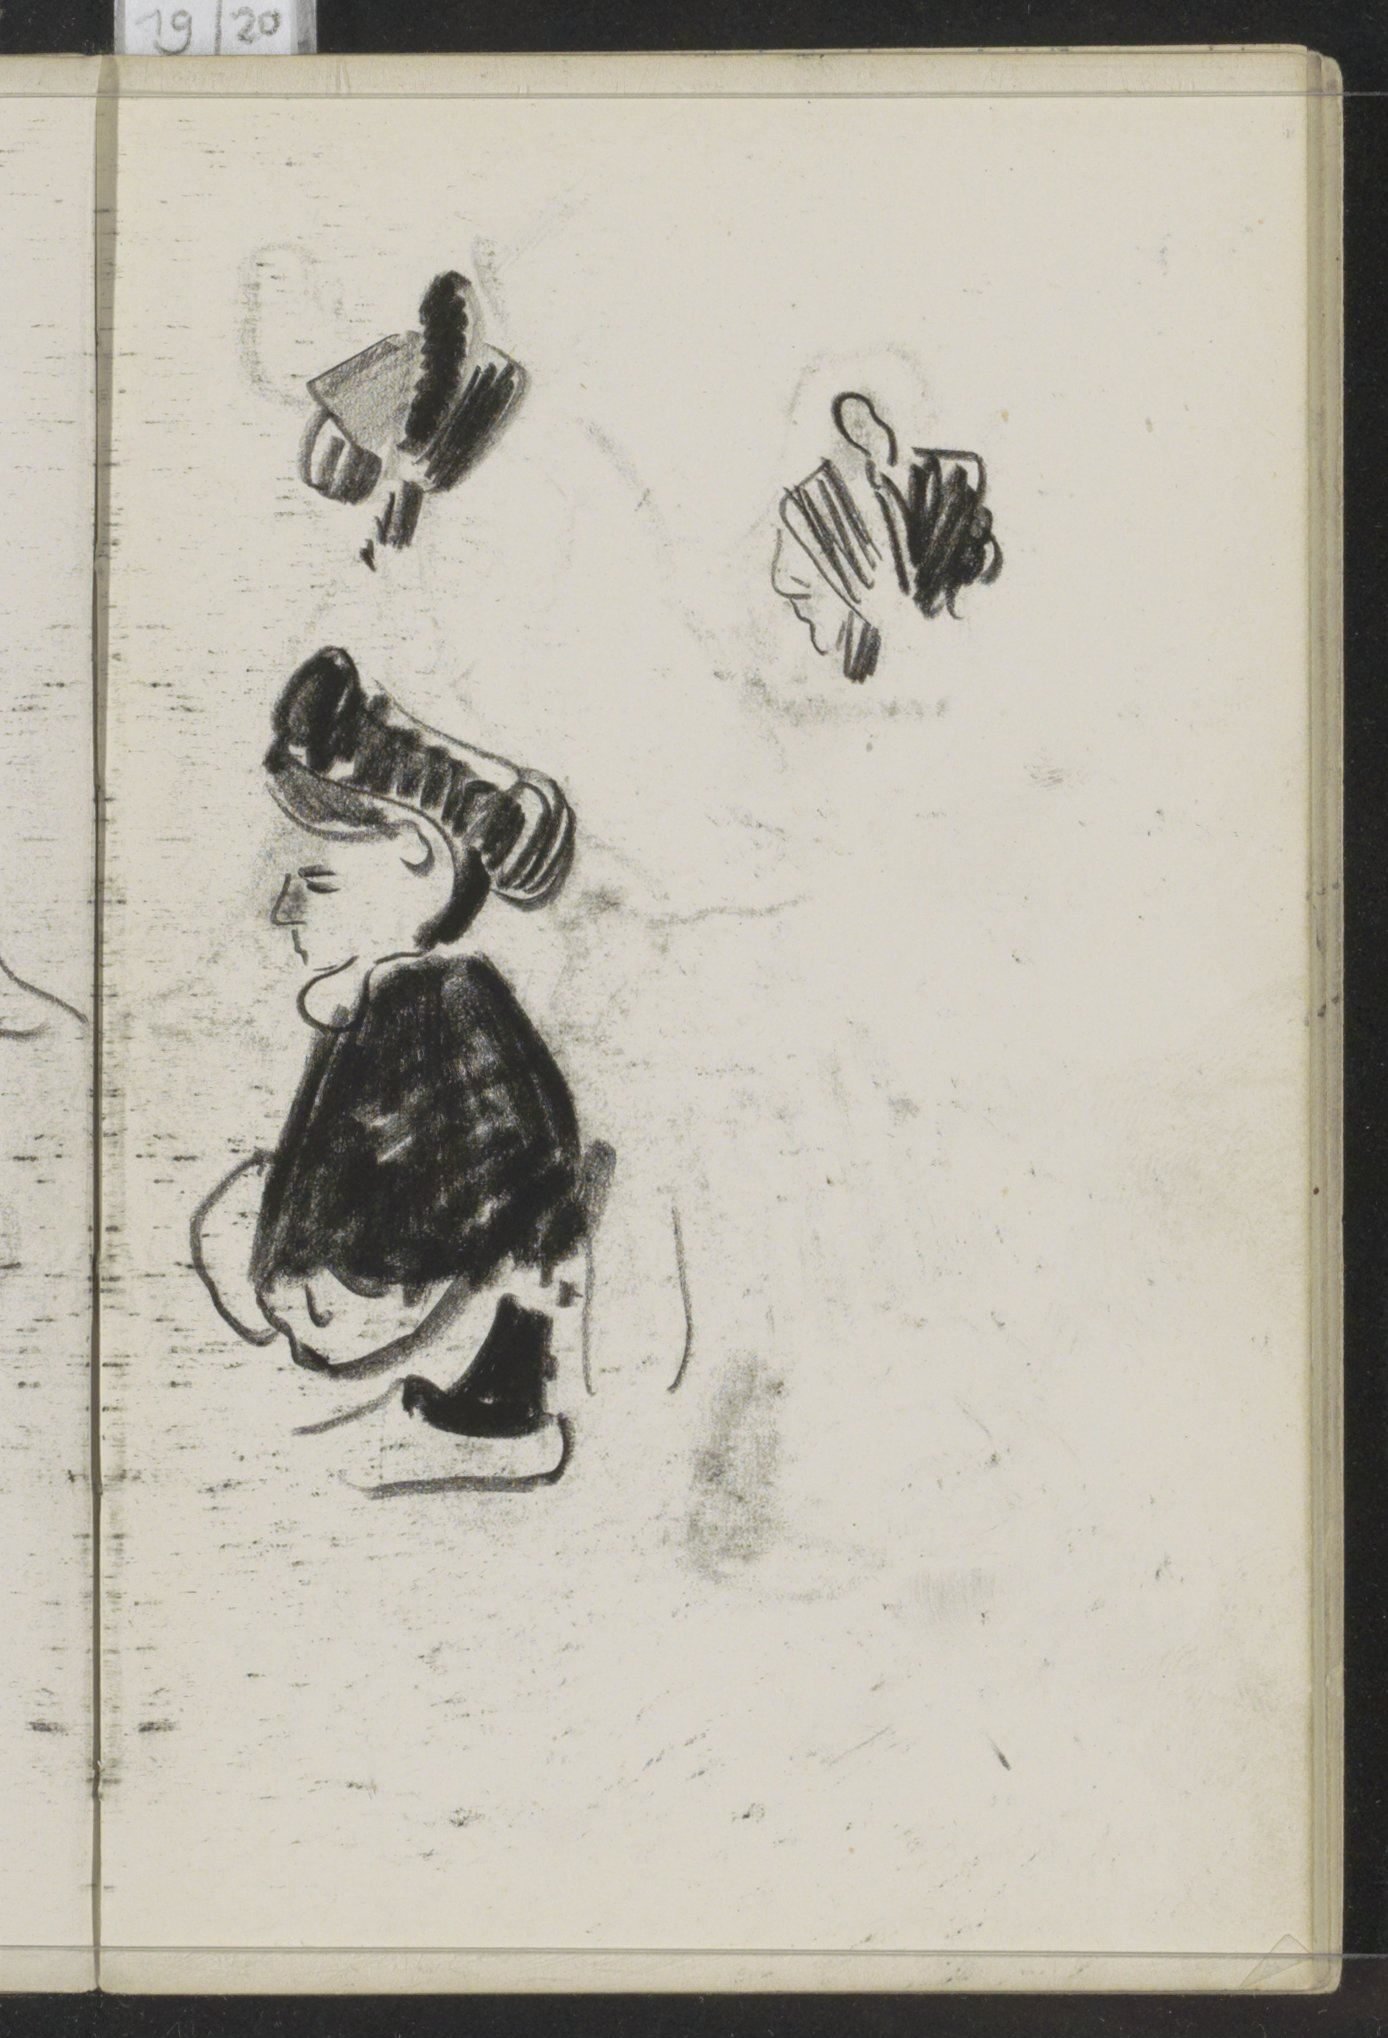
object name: sketchbook leaf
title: Vrouw met een hoed en een voet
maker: carel adolph lion cachet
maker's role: draughtsman, print maker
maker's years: 1864-1945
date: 1874-1945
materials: chalk, paper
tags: head (human) (+ female (human being) (not to be used where -aa- is prescribed)), foot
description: Tevens twee studies. Blad 17 recto uit een schetsboek met 41 bladen.